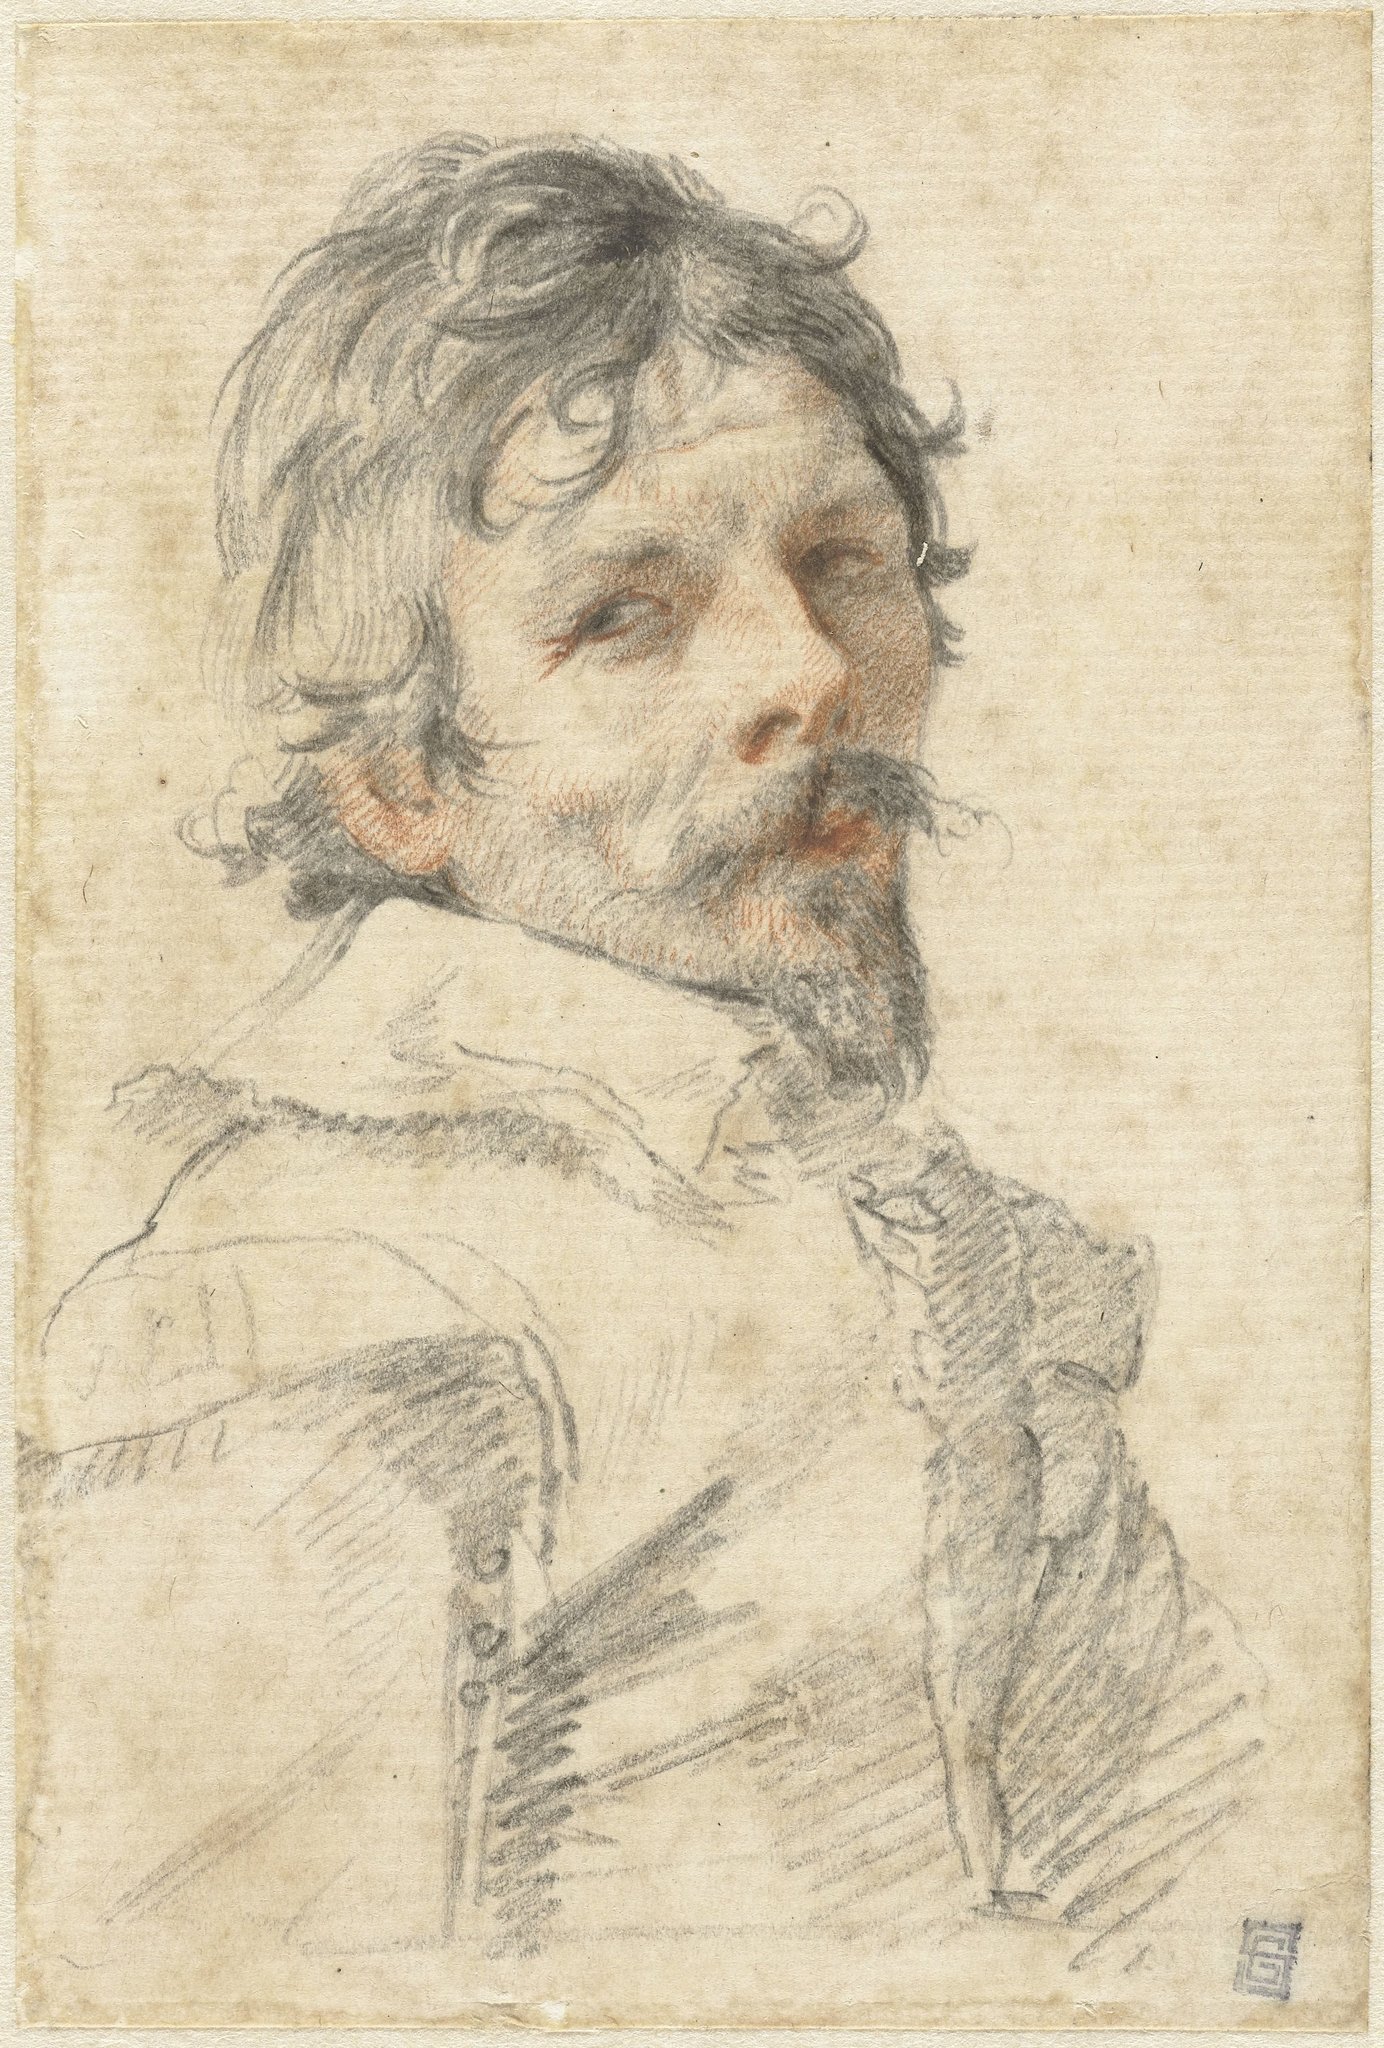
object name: drawing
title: Zelfportret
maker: claude mellan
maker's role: draughtsman, print maker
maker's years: 1598-1688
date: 1635-1688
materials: chalk, paper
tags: paris, print maker, draughtsman, claude mellan, historical persons, portrait, self-portrait of painter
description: Claude Mellan was behalve schilder en tekenaar vooral graveur. Hij had een geheel eigen, virtuose techniek. Zijn omvangrijke grafische oeuvre omvat bijna 400 bladen, waarvan de helft uit portretten bestaat.